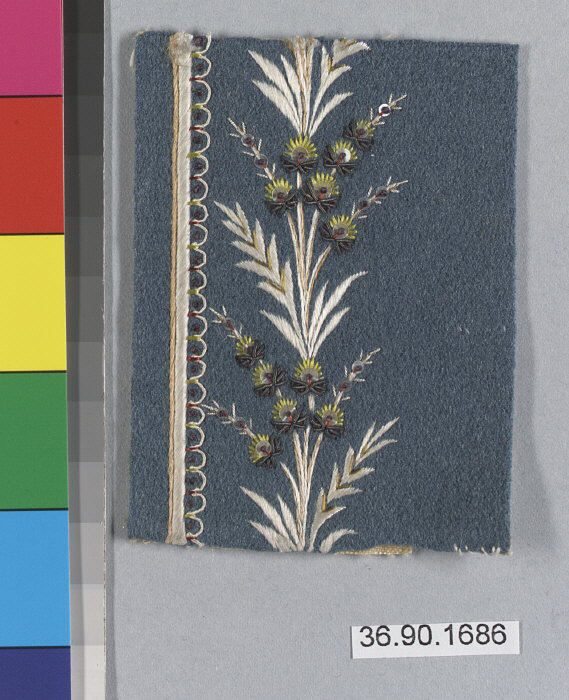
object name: sample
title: Embroidery sample for a man’s suit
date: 1785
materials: metal thread, silk, wool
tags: flowers